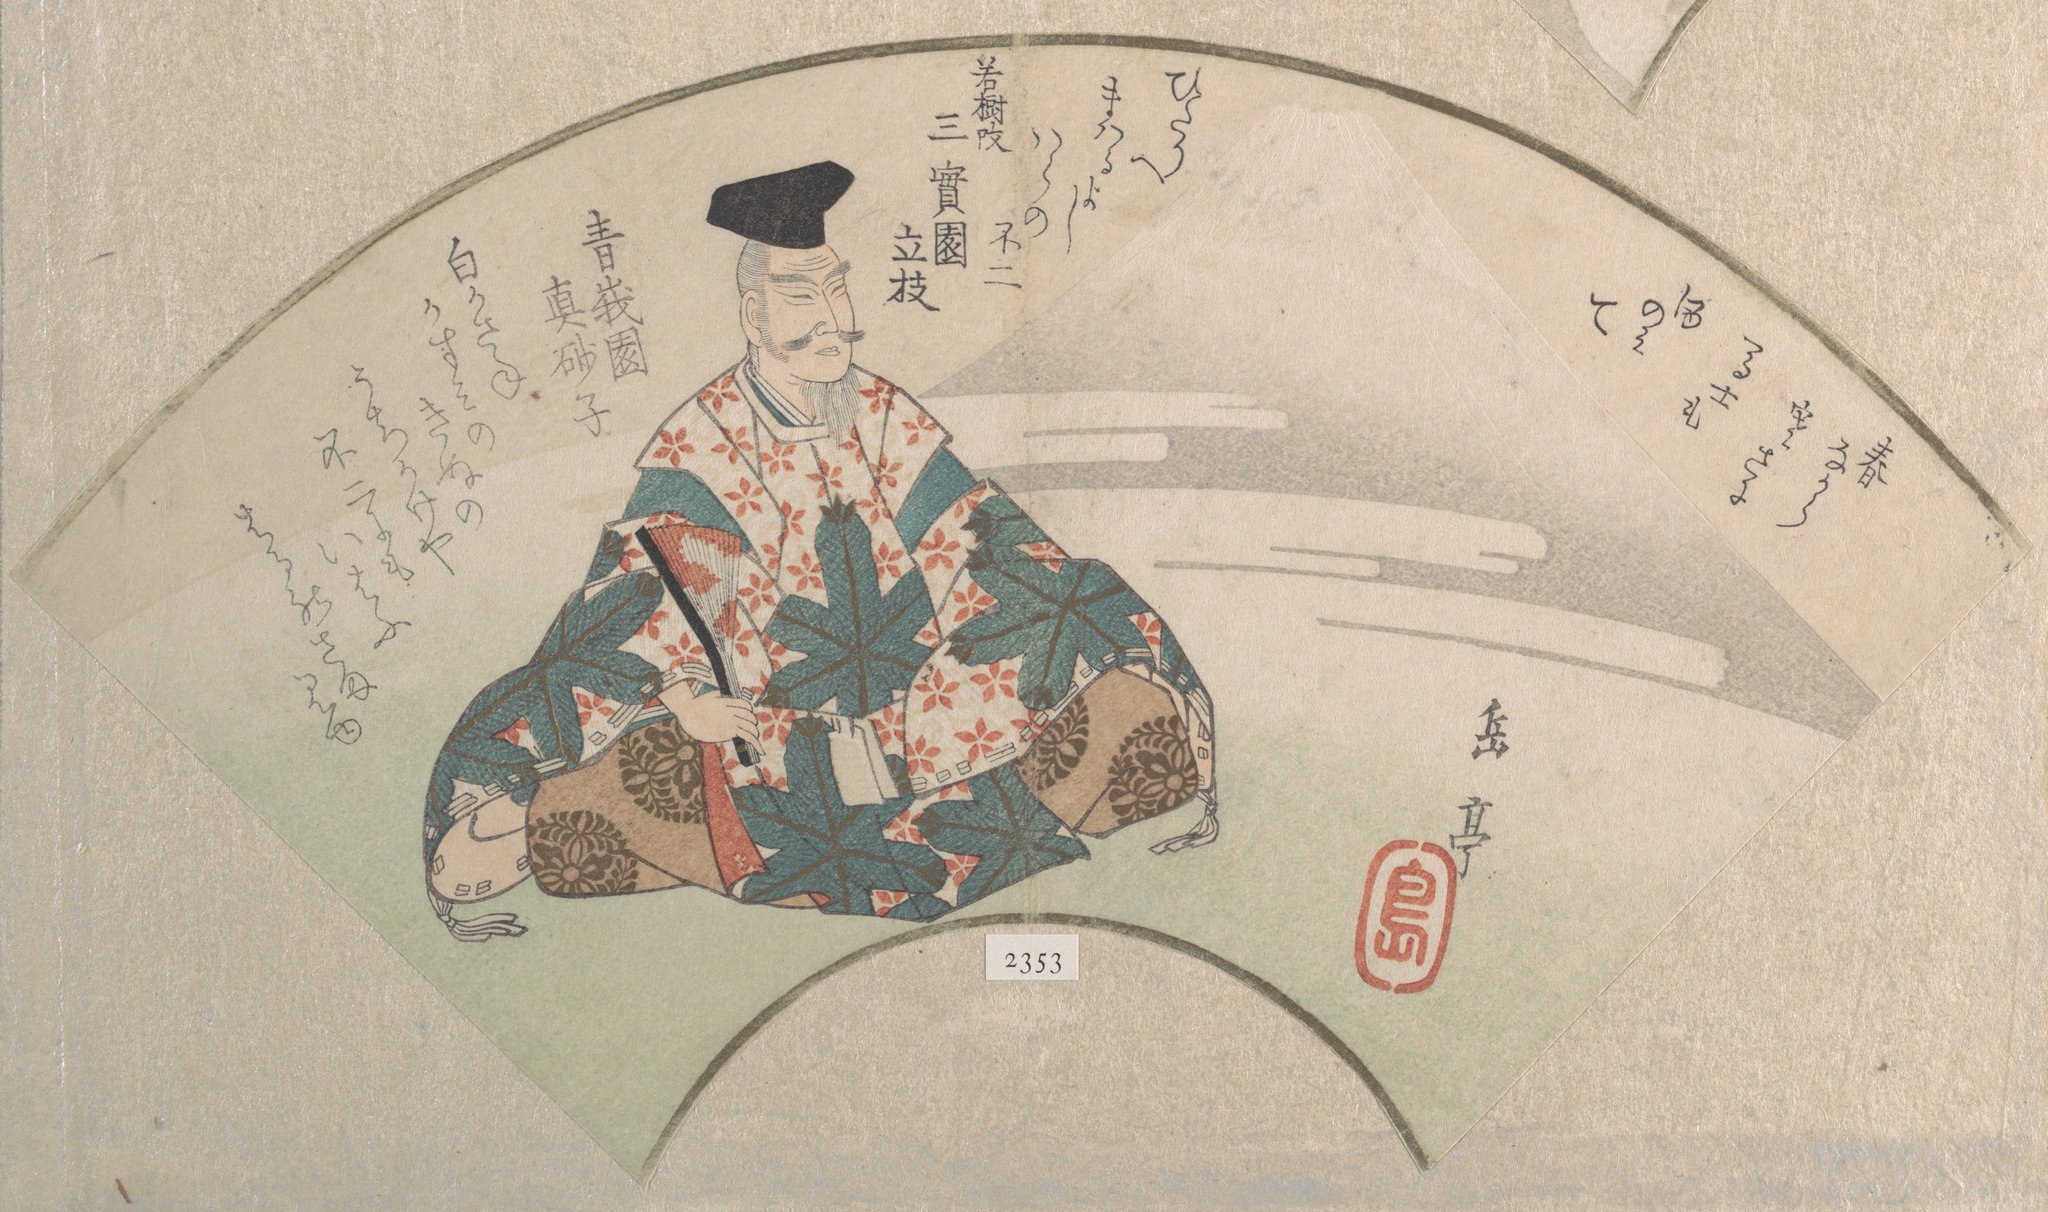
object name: print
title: A Poet and Mount Fuji From the Spring Rain Collection (Harusame shū), vol. 3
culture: japanese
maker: yashima gakutei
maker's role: artist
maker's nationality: japanese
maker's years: 1786-1868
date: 1820-1829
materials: ink, paper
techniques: surimono, woodblock print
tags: men,mountains